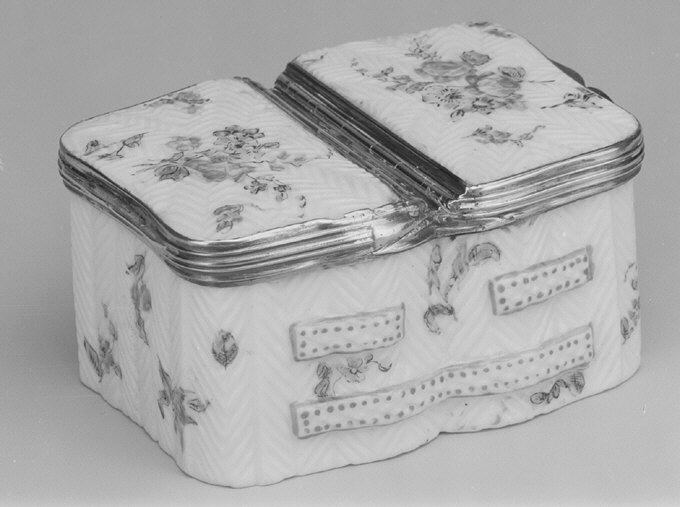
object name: snuffbox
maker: mennecy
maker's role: factory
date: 1750-1756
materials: silver, soft paste porcelain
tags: flowers